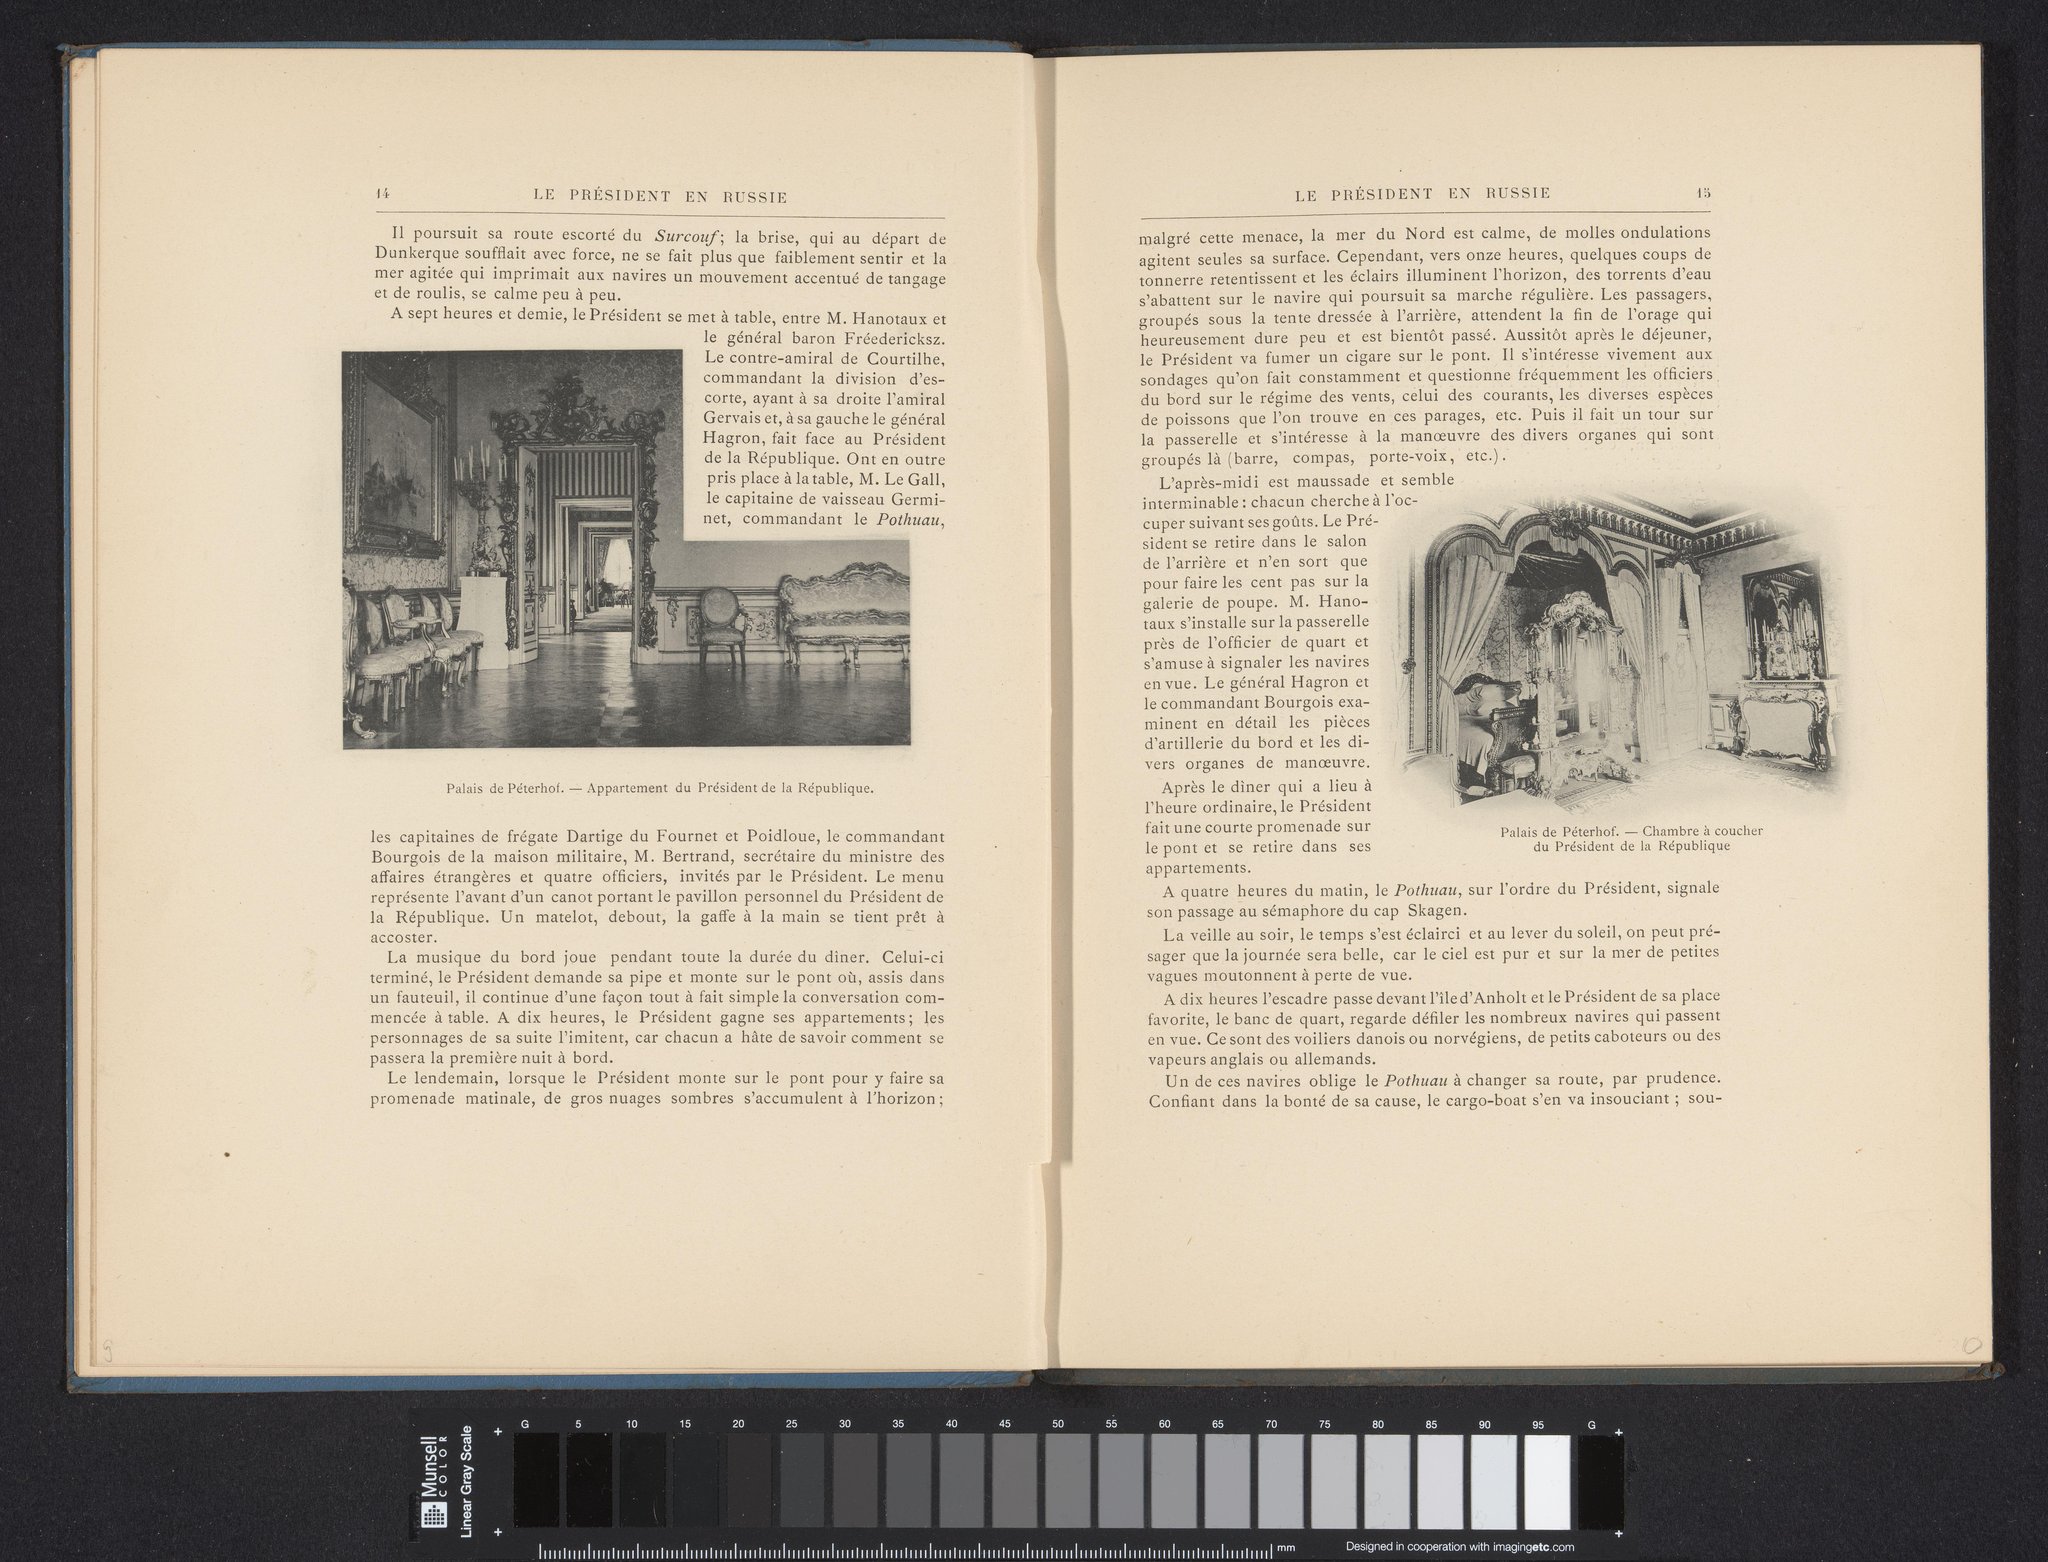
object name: photomechanical print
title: Interieur van het verblijf van president Félix Faure in het Paleizencomplex van Peterhof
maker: Anonymous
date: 1897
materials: paper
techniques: photograph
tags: palace, interior ~ representation of a building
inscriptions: inscription: ‘Palais de Péterhof. (...) de la République.’